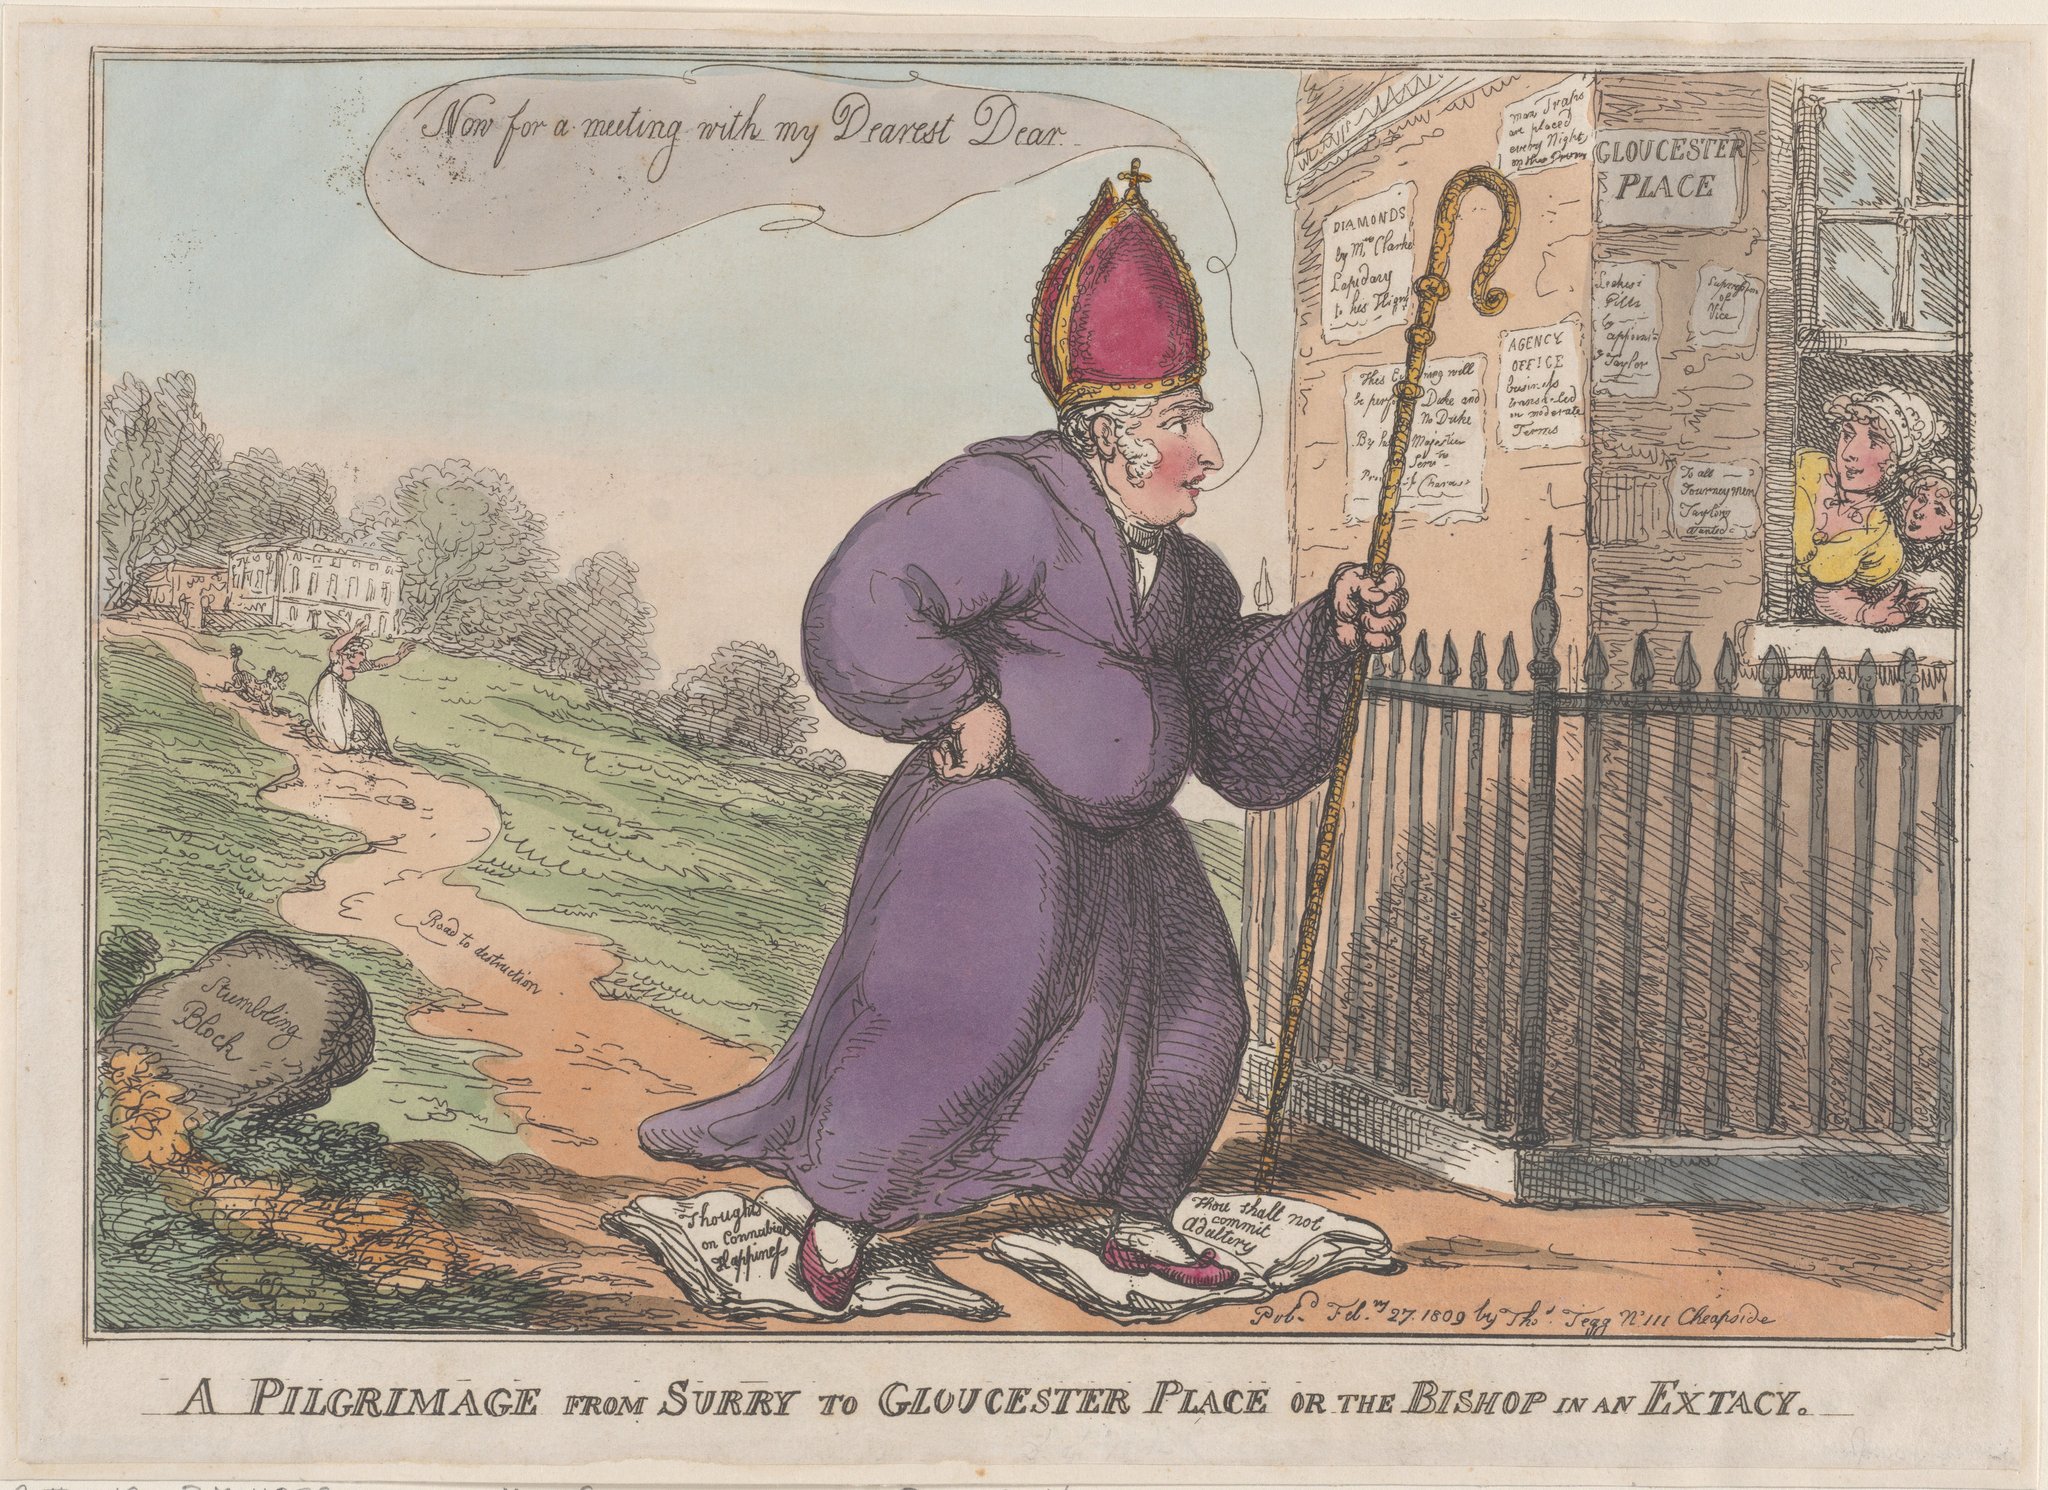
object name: print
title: A Pilgrimage from Surry to Gloucester Place or the Bishop is an Extacty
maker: thomas rowlandson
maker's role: artist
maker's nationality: british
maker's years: 1757-1827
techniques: etching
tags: satire,men,women